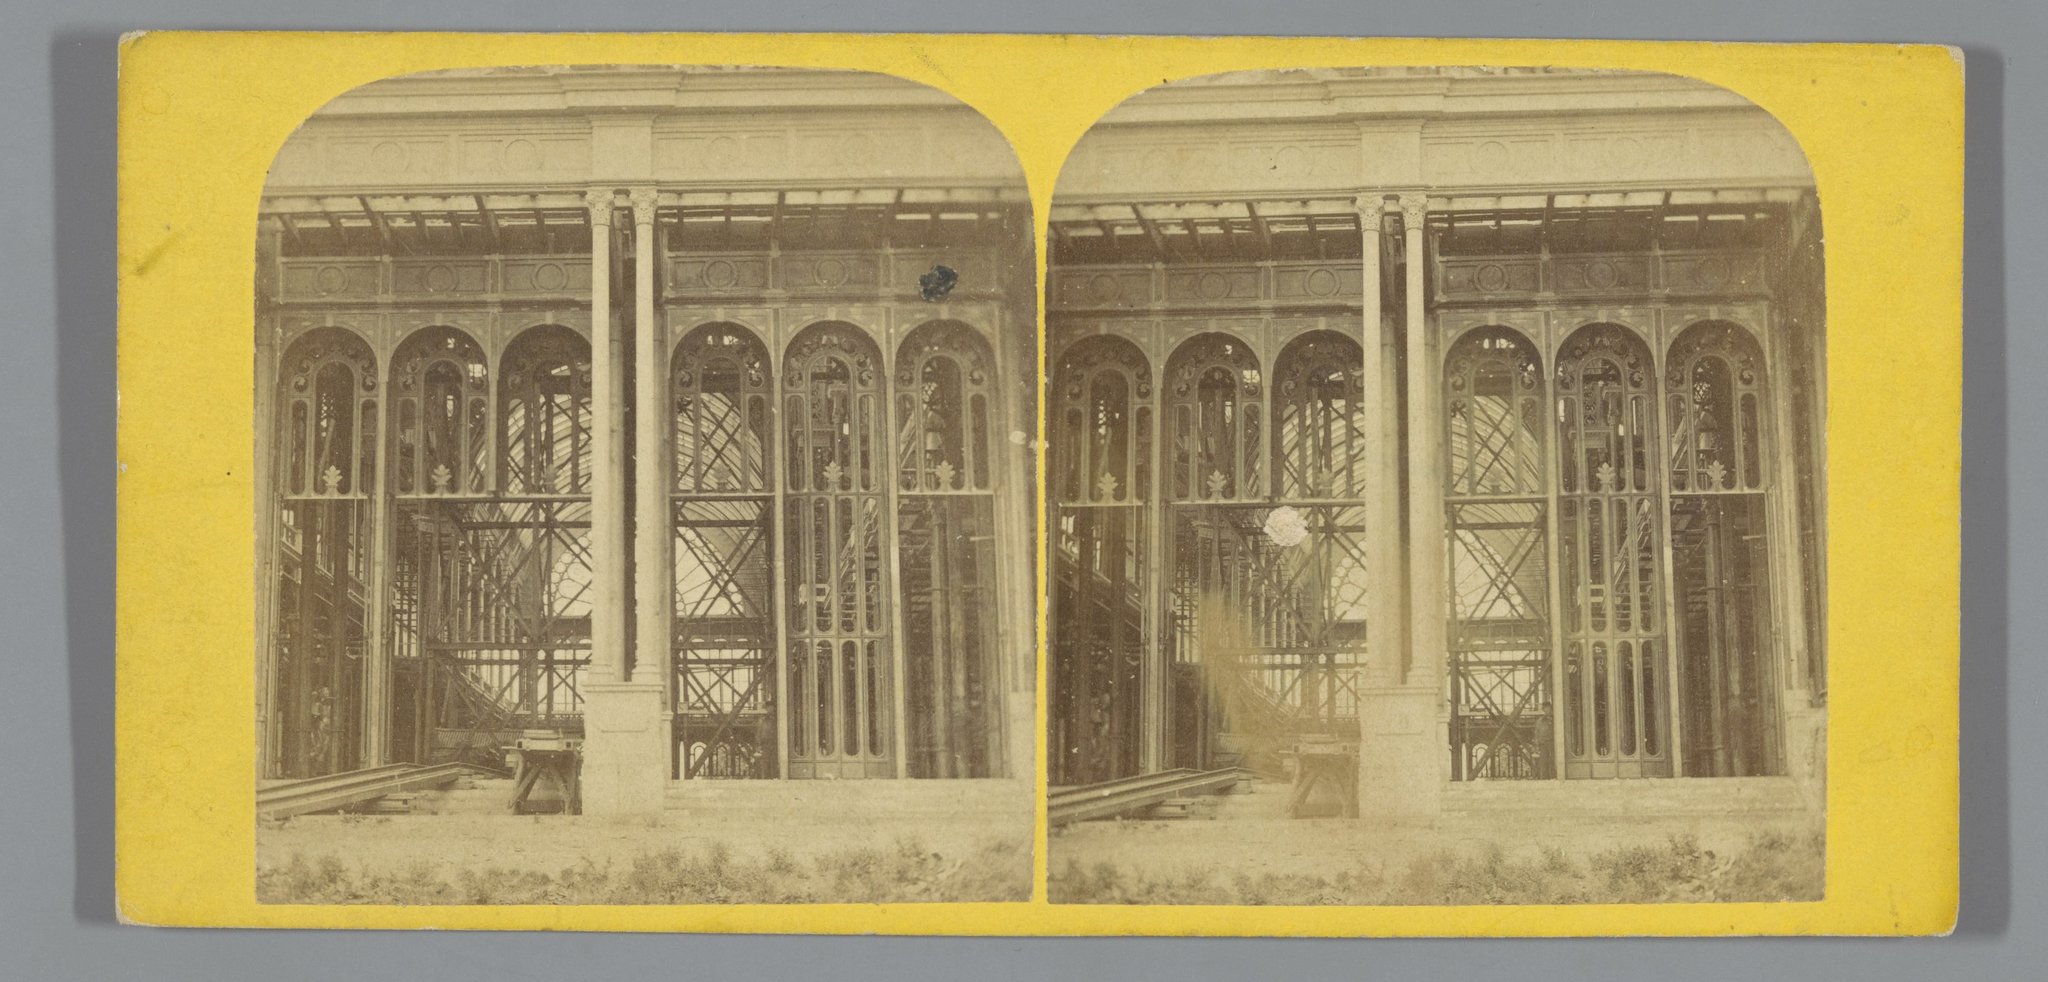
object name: stereograph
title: Gezicht op het interieur van het Paleis voor Volksvlijt in Amsterdam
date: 1860-1885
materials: cardboard, photographic support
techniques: albumen print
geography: amsterdam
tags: palace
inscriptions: inscription: ‘No. 139./ HET PALEIS VOOR VOLKSVLIJT/ te Amsterdam./ VAN BINNEN. No. 1./ A. JAGER, WATER 110, TE AMSTERDAM.’